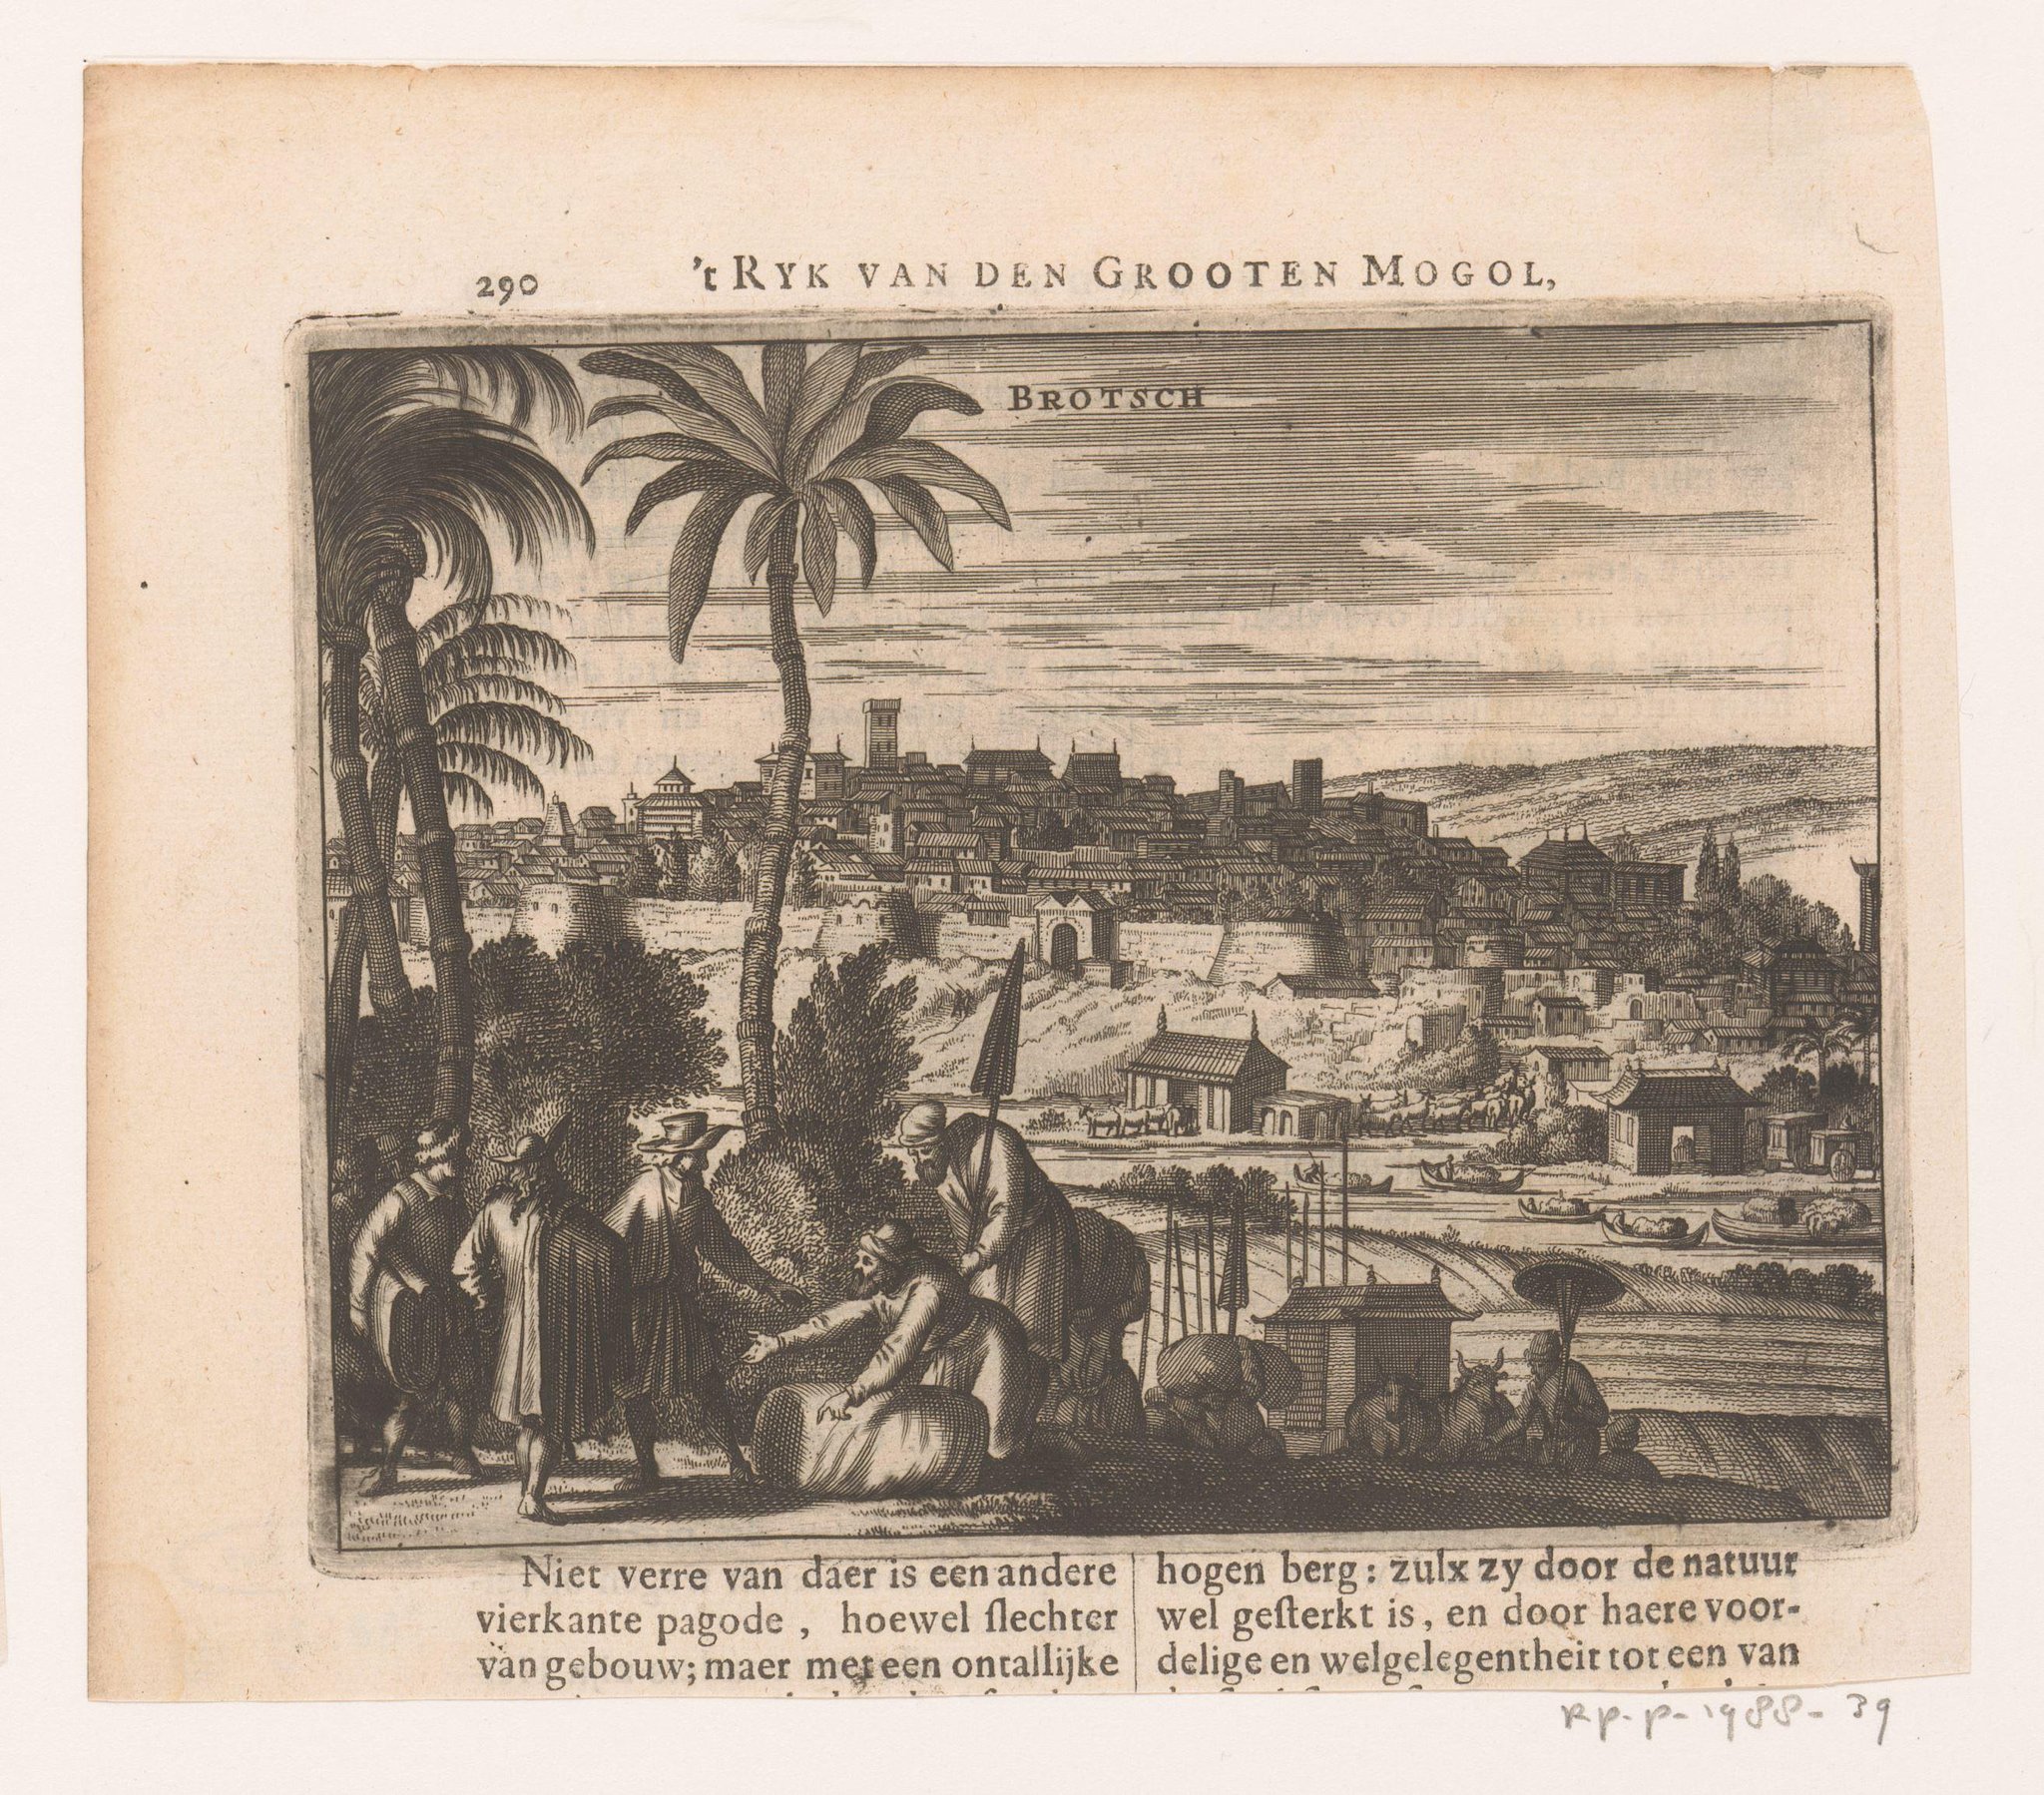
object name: book illustration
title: Gezicht op de stad Bharuch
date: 1672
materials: paper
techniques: engraving, etching, letterpress printing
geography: amsterdam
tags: prospect of city, town panorama, silhouette of city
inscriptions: collector's mark: Lugt 2228, collector's mark: Lugt 2760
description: Prent uit: Dapper, Olfert. Asia, of naukeurige beschryving van het rijk des grooten Mogols (...). Amsterdam: Jakob van Meurs, 1672, p. 290.